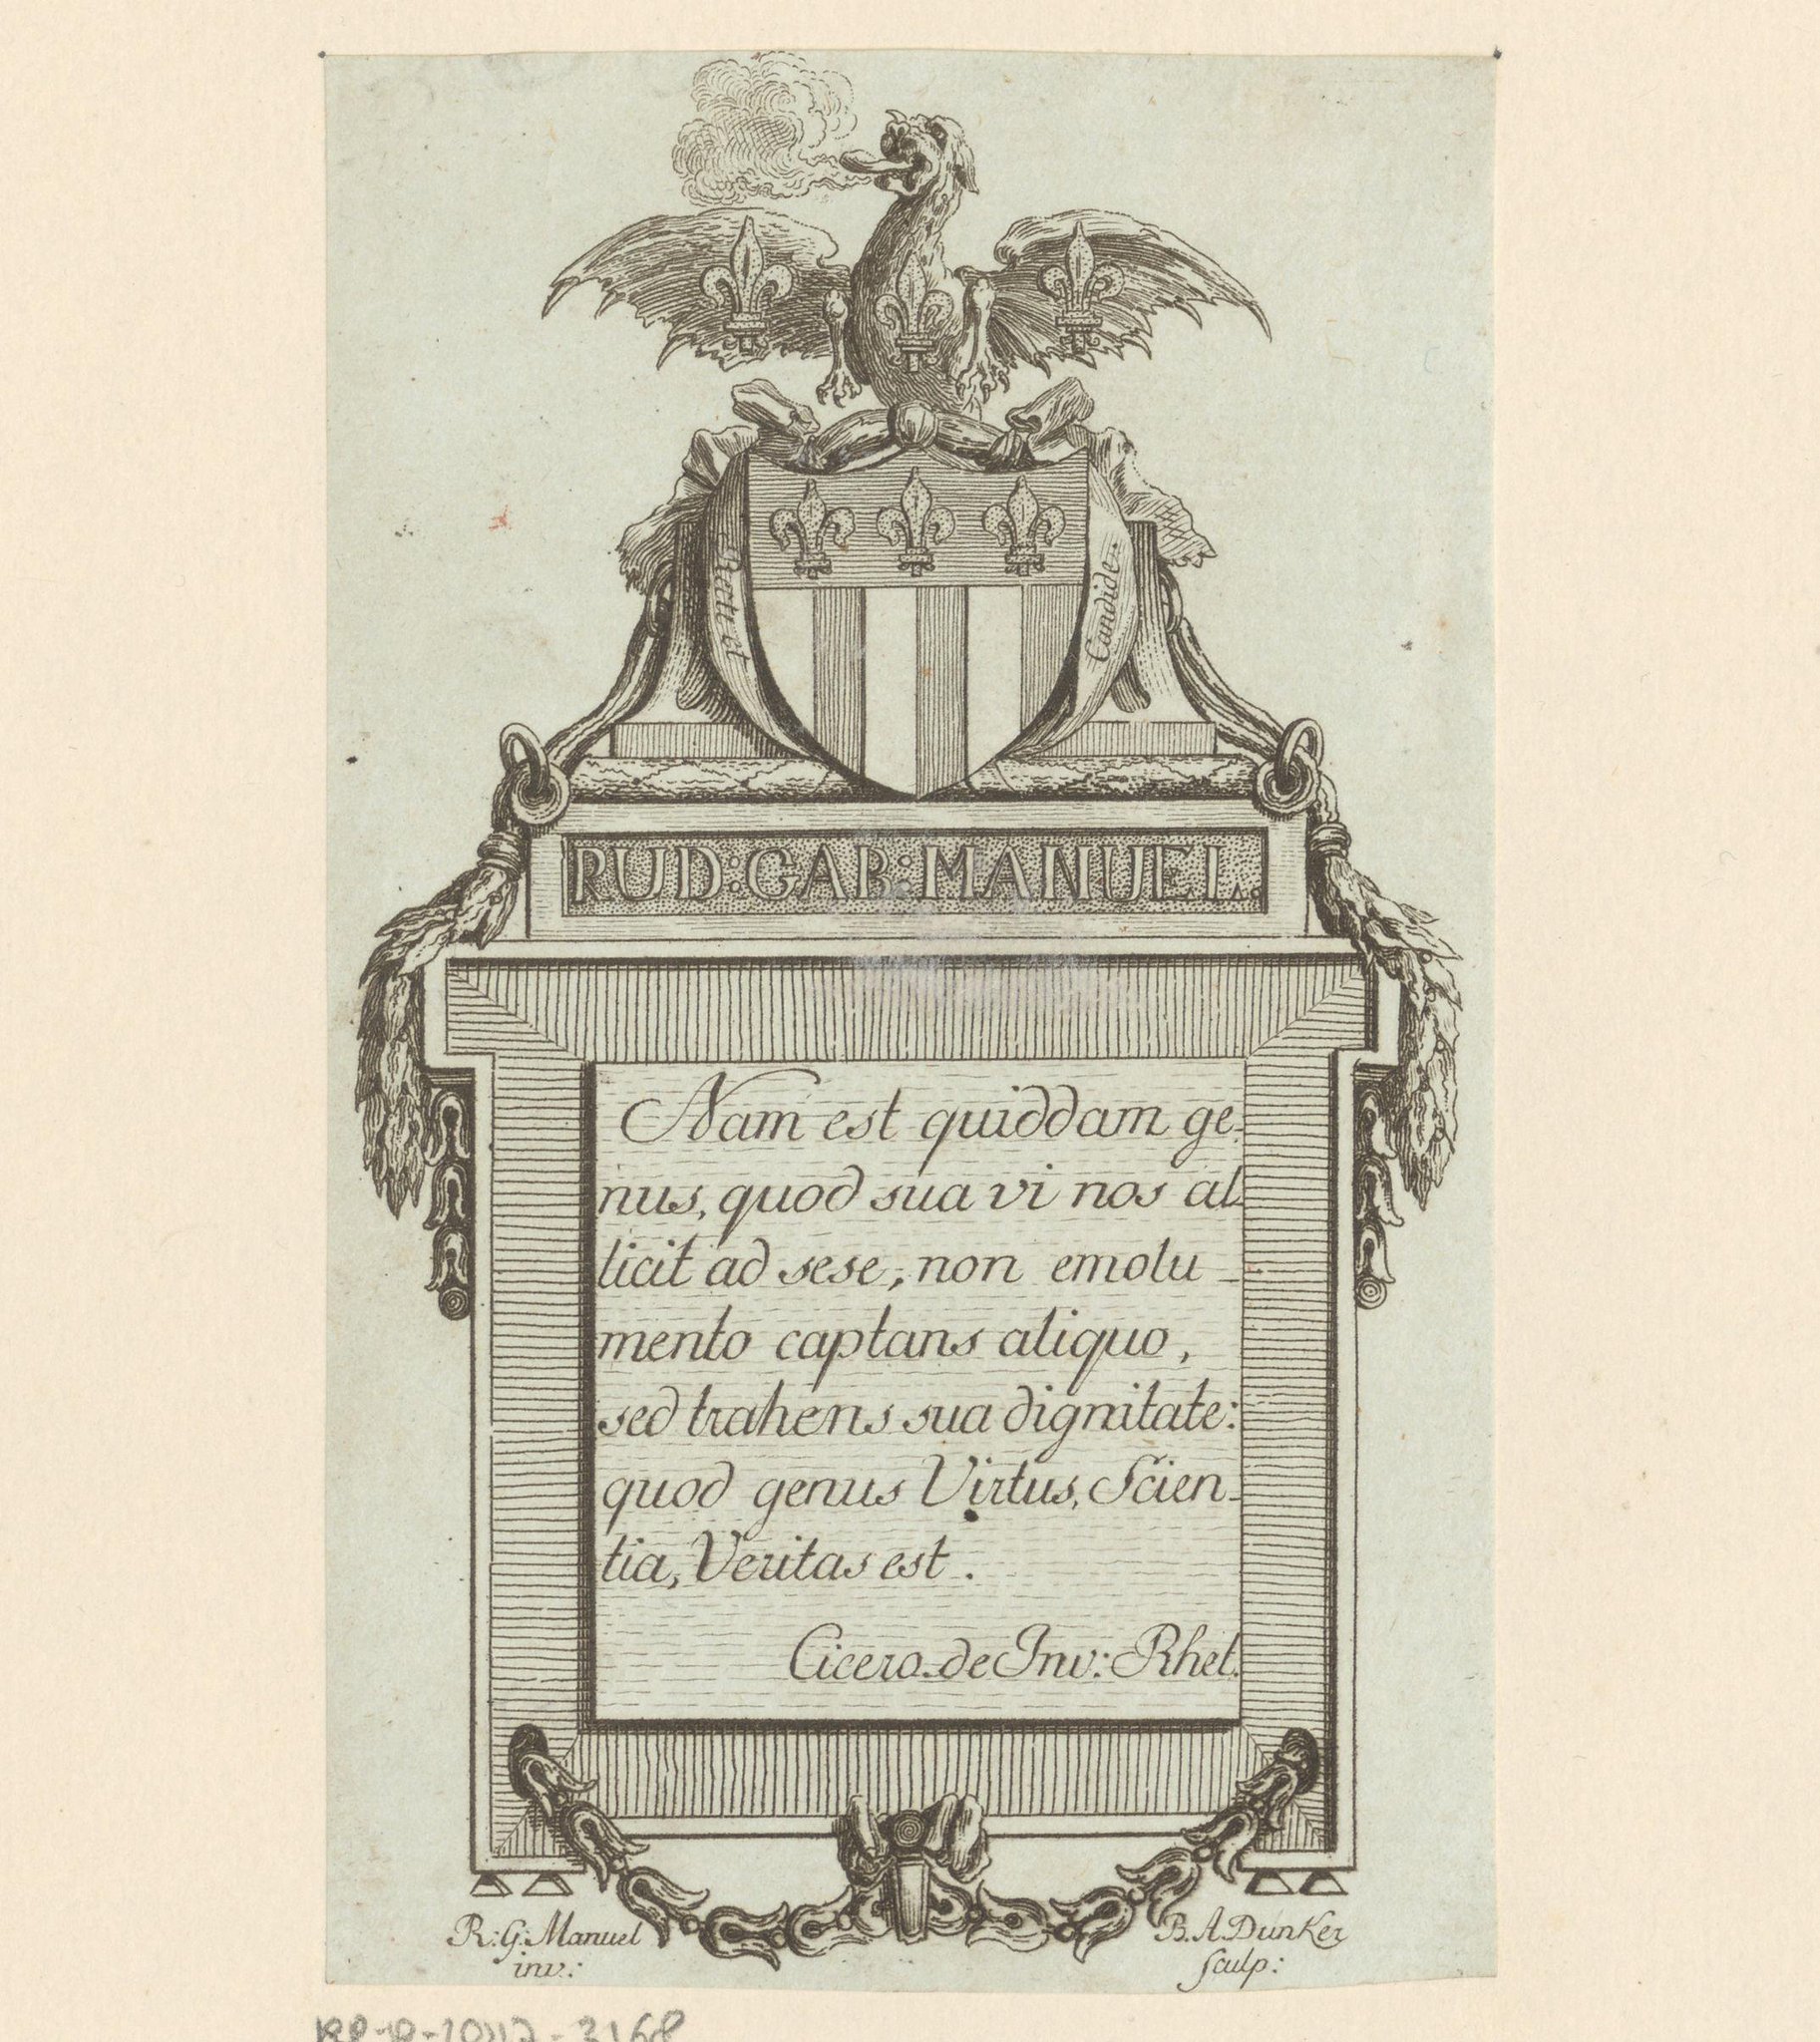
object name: bookplate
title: Ex libris van Rudolph Gabriel Manuel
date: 1759-1807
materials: paper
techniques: etching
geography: switzerland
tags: rudolph gabriel manuel, fleur-de-lis ~ ornament, predatory birds: eagle, armorial bearing, heraldry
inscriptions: inscription: ‘Gerster 1465’